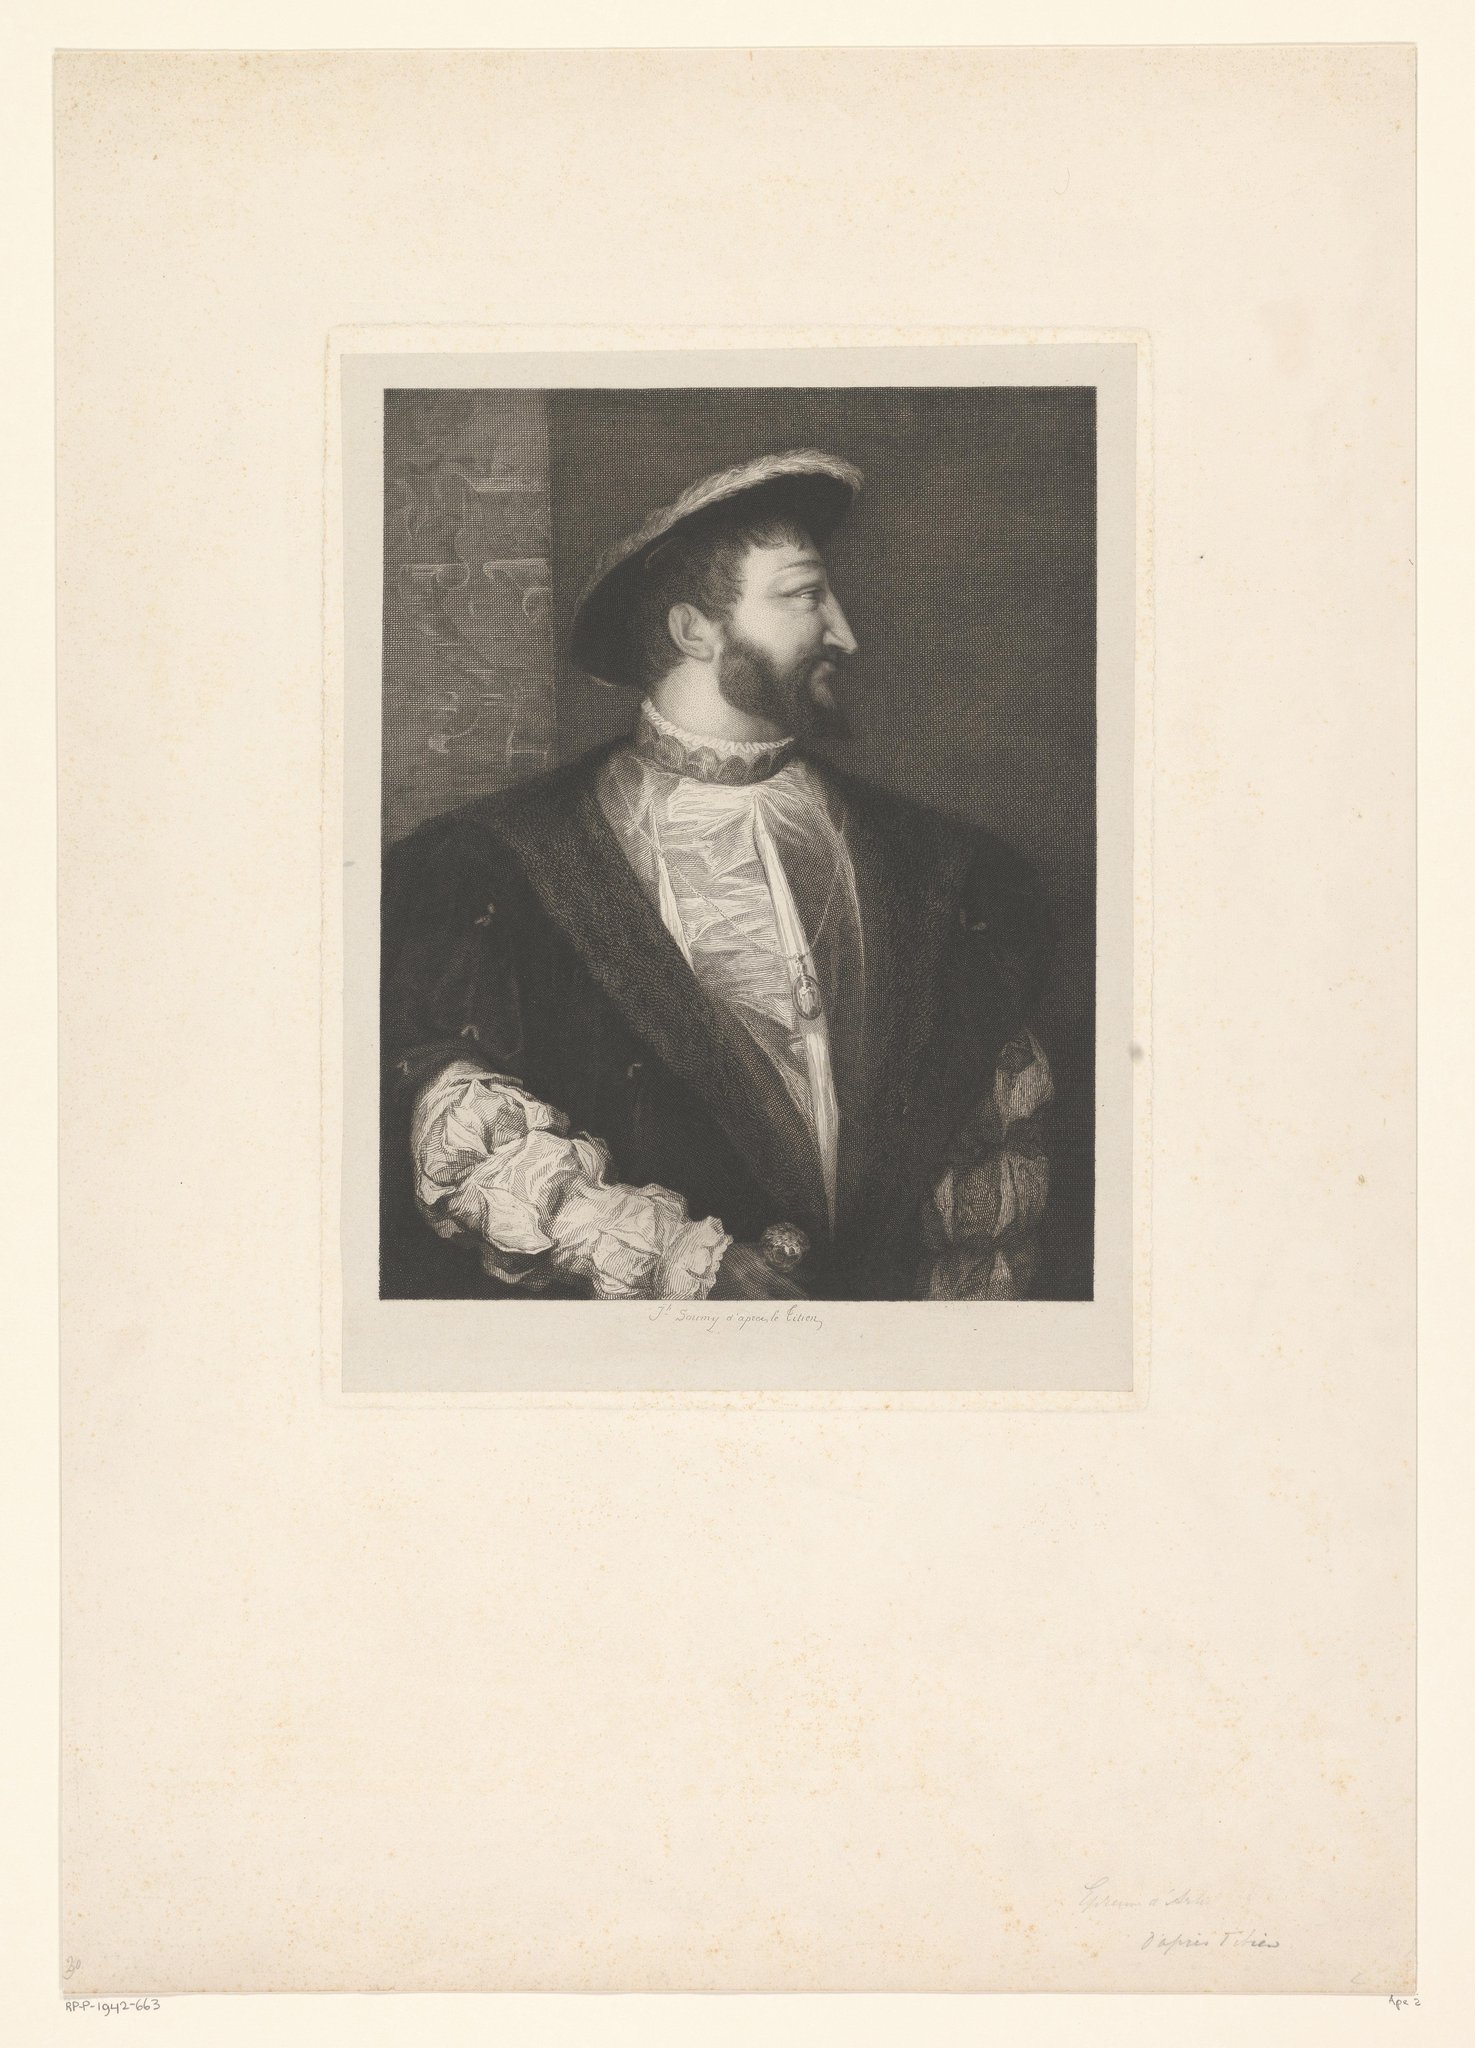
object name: print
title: Portret van Frans I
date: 1846-1863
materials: paper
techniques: engraving, etching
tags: frans i van valois-angoulême (koning van frankrijk), historical persons, king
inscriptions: collector's mark: Lugt 2228